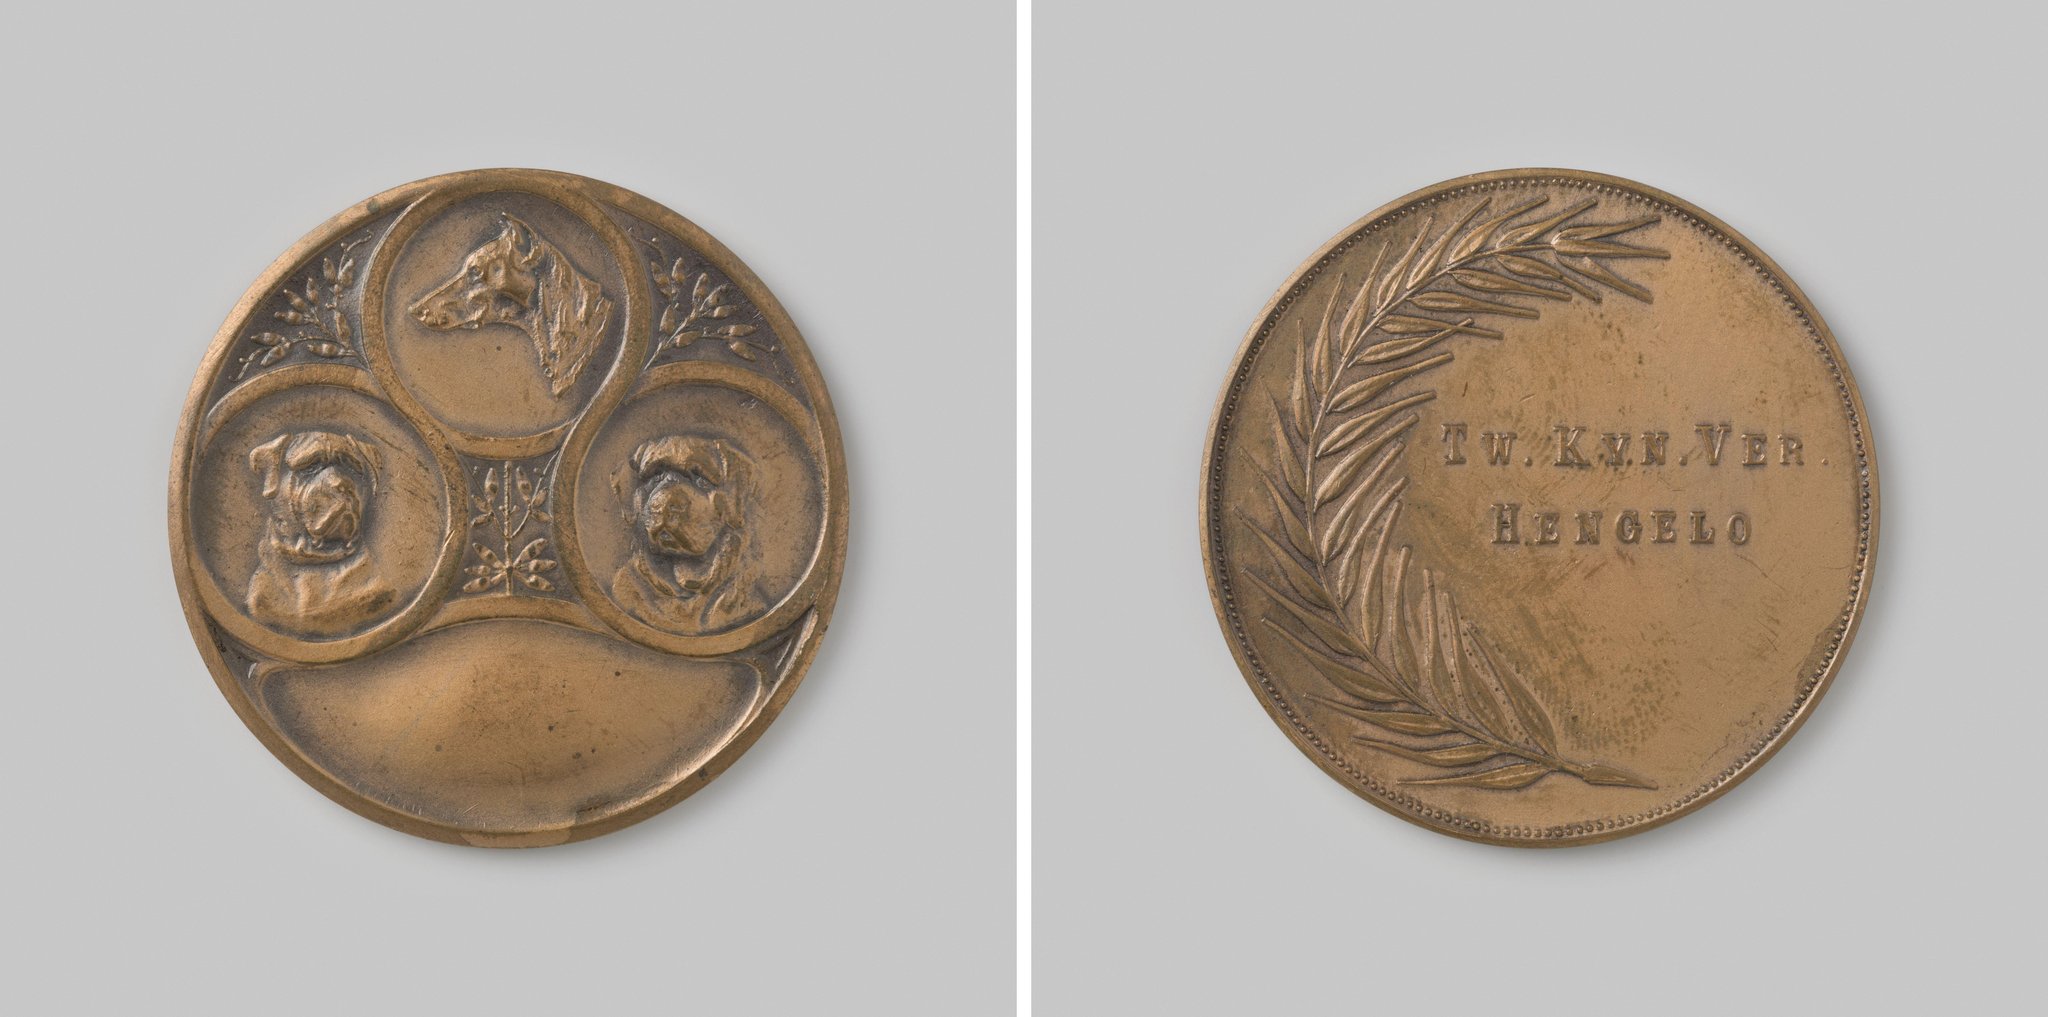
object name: history medal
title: Prijspenning van de Twentsche Kynologen Vereeniging te Hengelo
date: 1900-1950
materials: bronze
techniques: striking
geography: netherlands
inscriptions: inscription: ‘TW. KYN. VER. / HENGELO’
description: Bronzen penning, op de voorzijde drie medaillons met hondenkoppen en een inscriptieruimte, op de keerzijde palmtak en opschrift, zonder inscripties